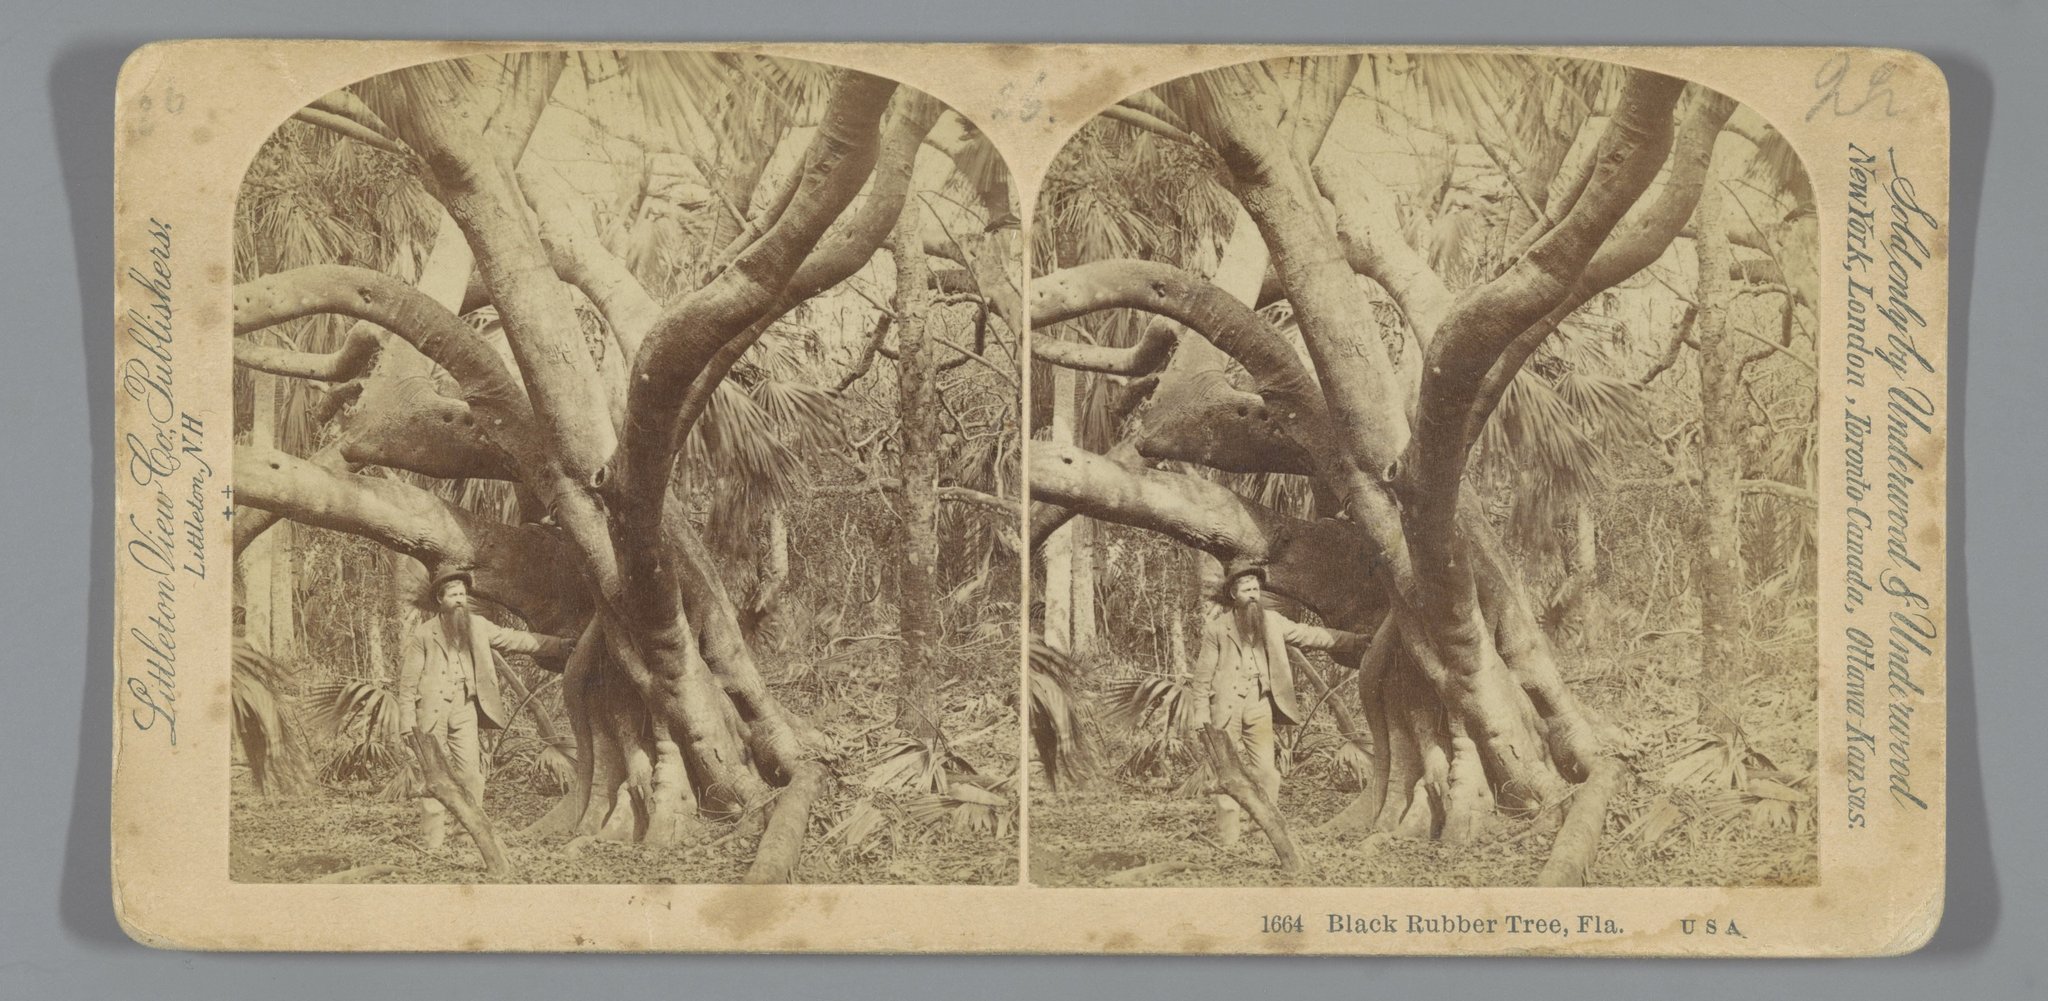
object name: stereograph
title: Black Rubber Tree, Fla. U.S.A.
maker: Anonymous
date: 1891-1909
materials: cardboard, paper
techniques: albumen print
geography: florida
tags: florida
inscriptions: number: ‘1664’, title: ‘Black Rubber Tree, Florida, U. S. A.’, number: ‘22’